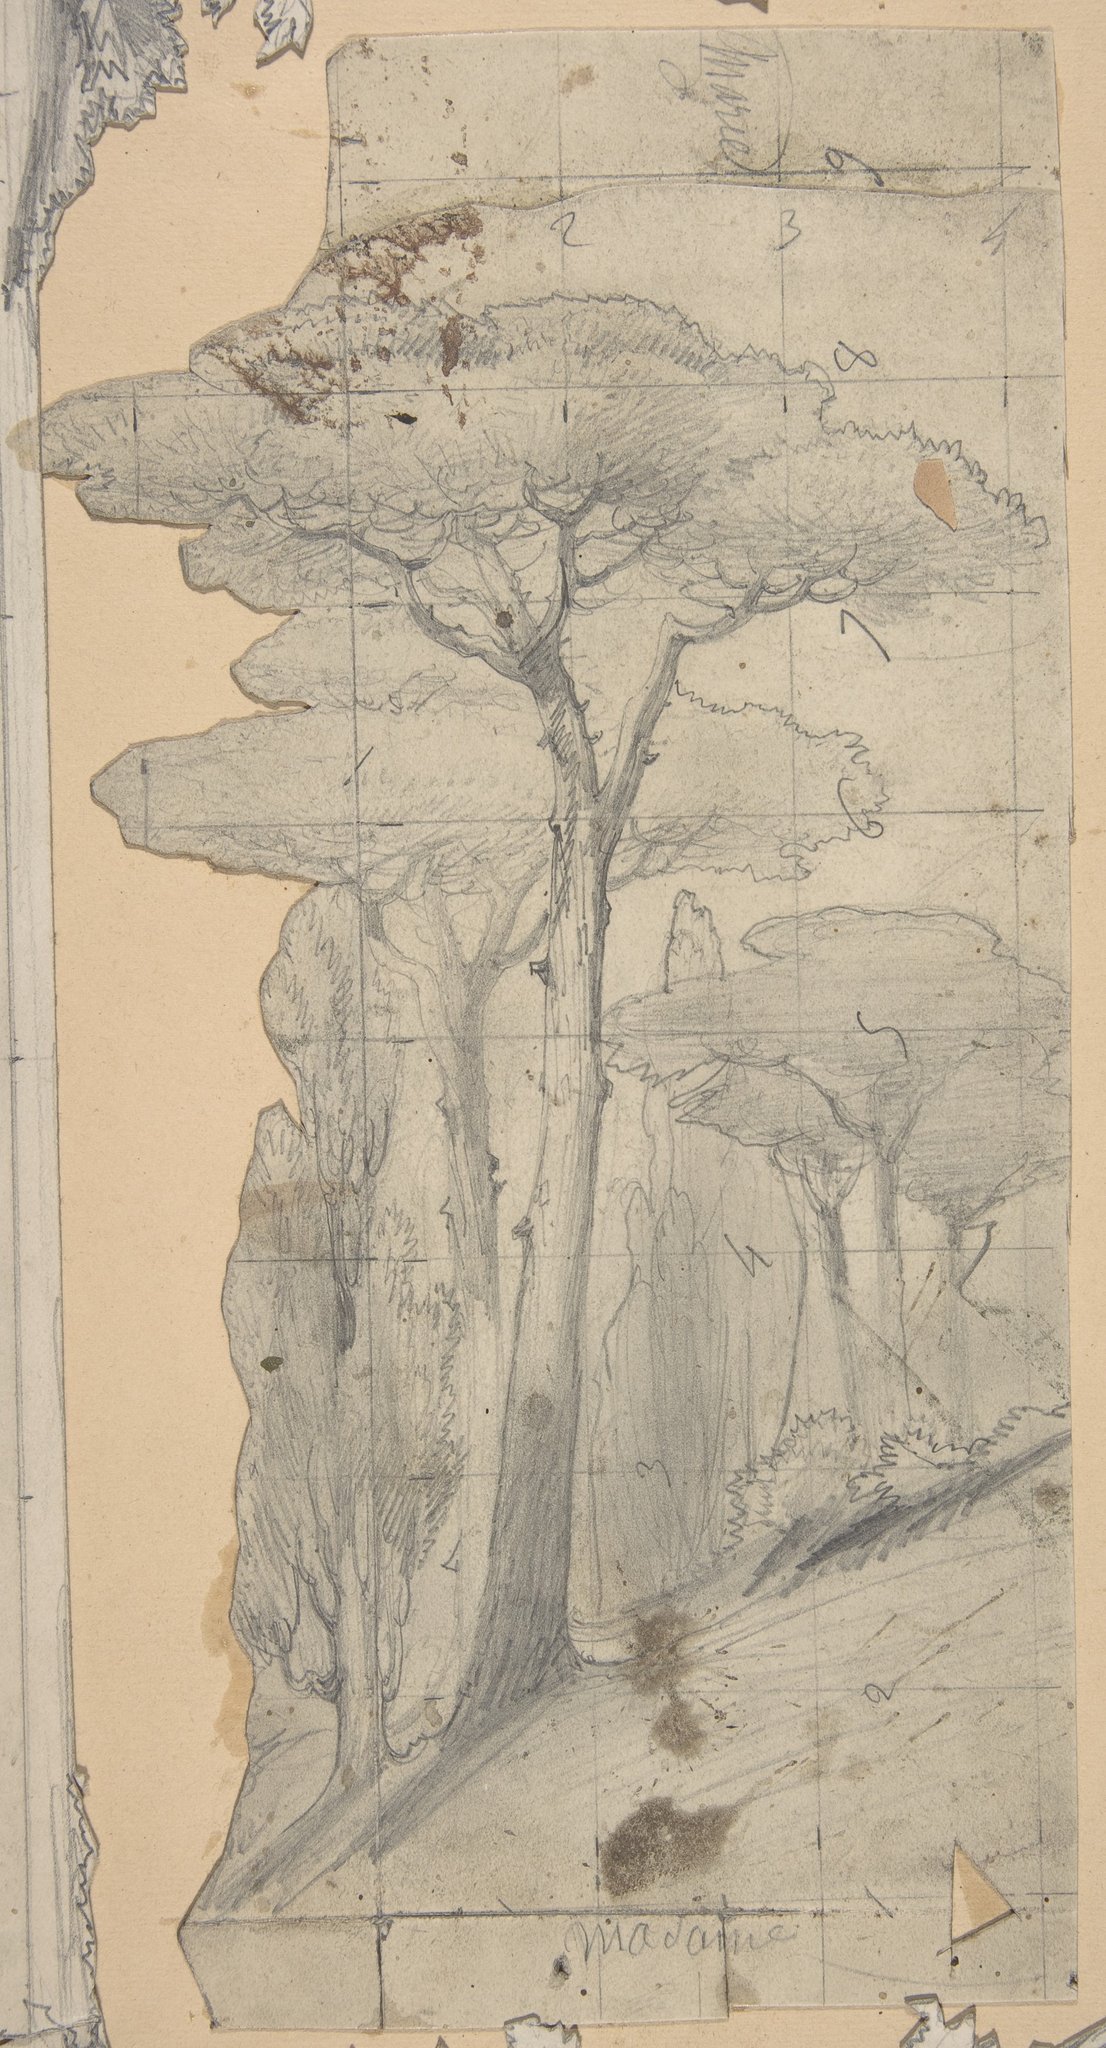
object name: drawing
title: Design for a Stage Set at the Opéra, Paris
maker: eugène cicéri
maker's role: artist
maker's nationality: french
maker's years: 1813-1890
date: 1830-1890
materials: graphite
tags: trees,stage design